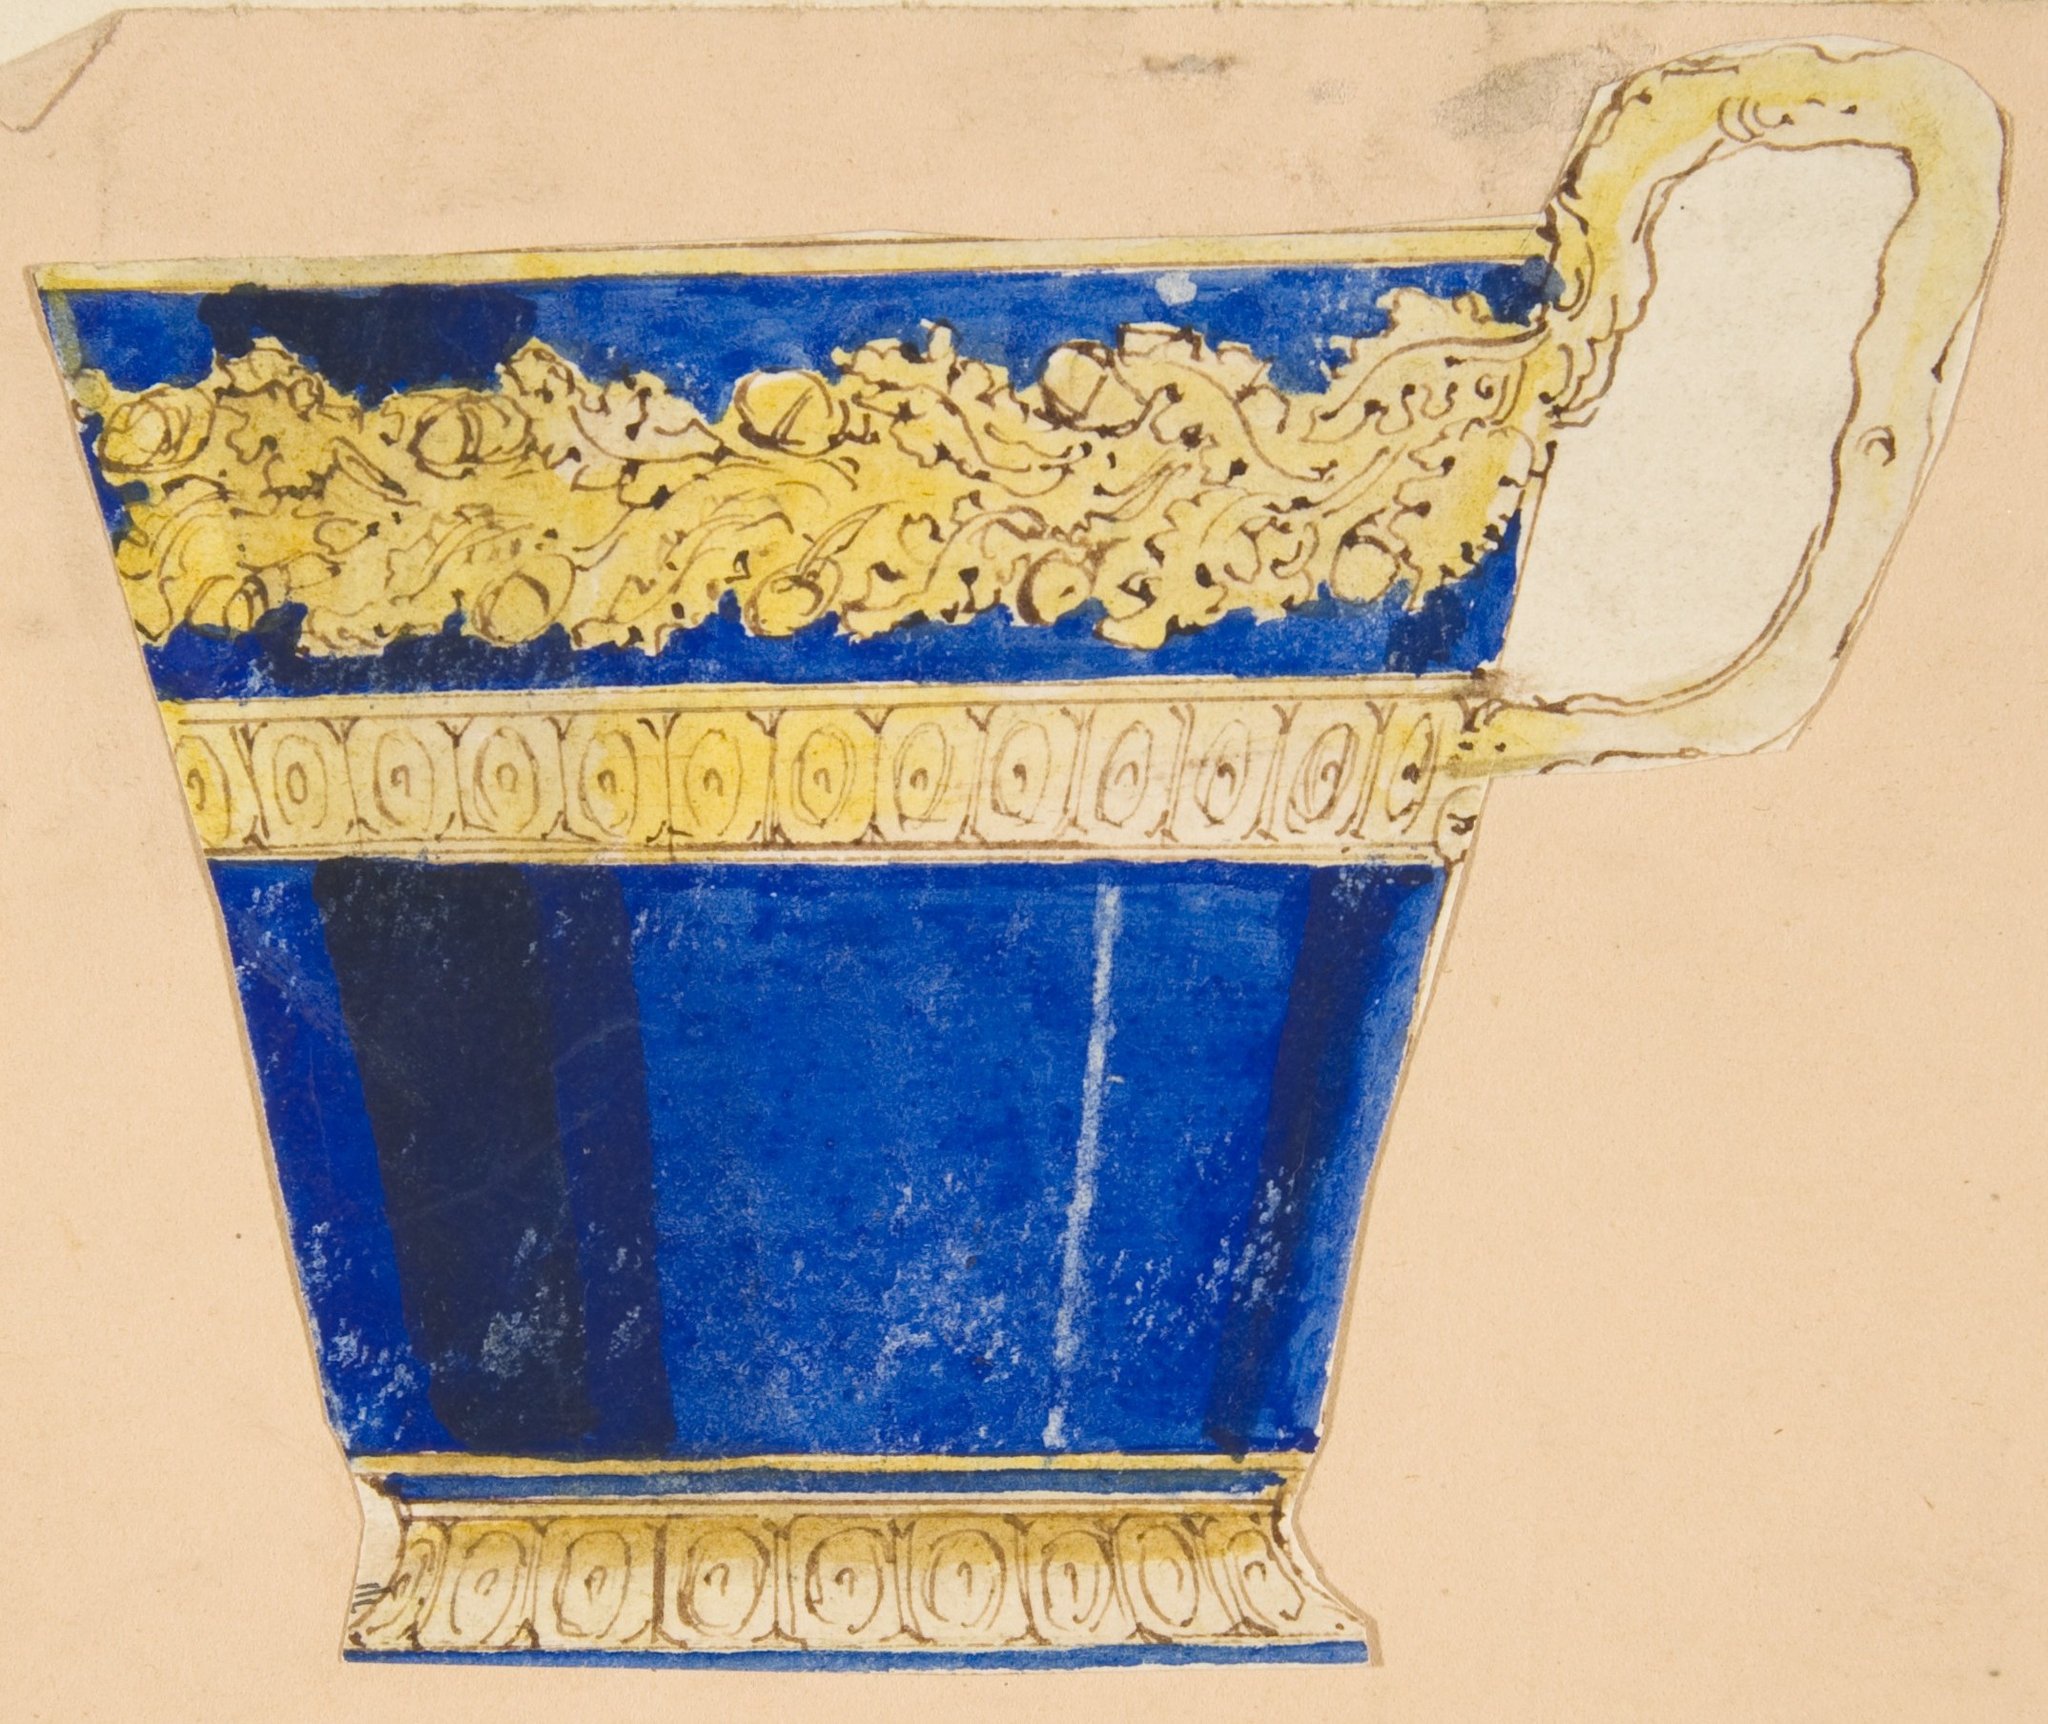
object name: drawing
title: Design for a cup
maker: anonymous, french, 19th century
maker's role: artist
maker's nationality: french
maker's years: 1800-1900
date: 1801-1900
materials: ink, watercolor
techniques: pen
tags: cups